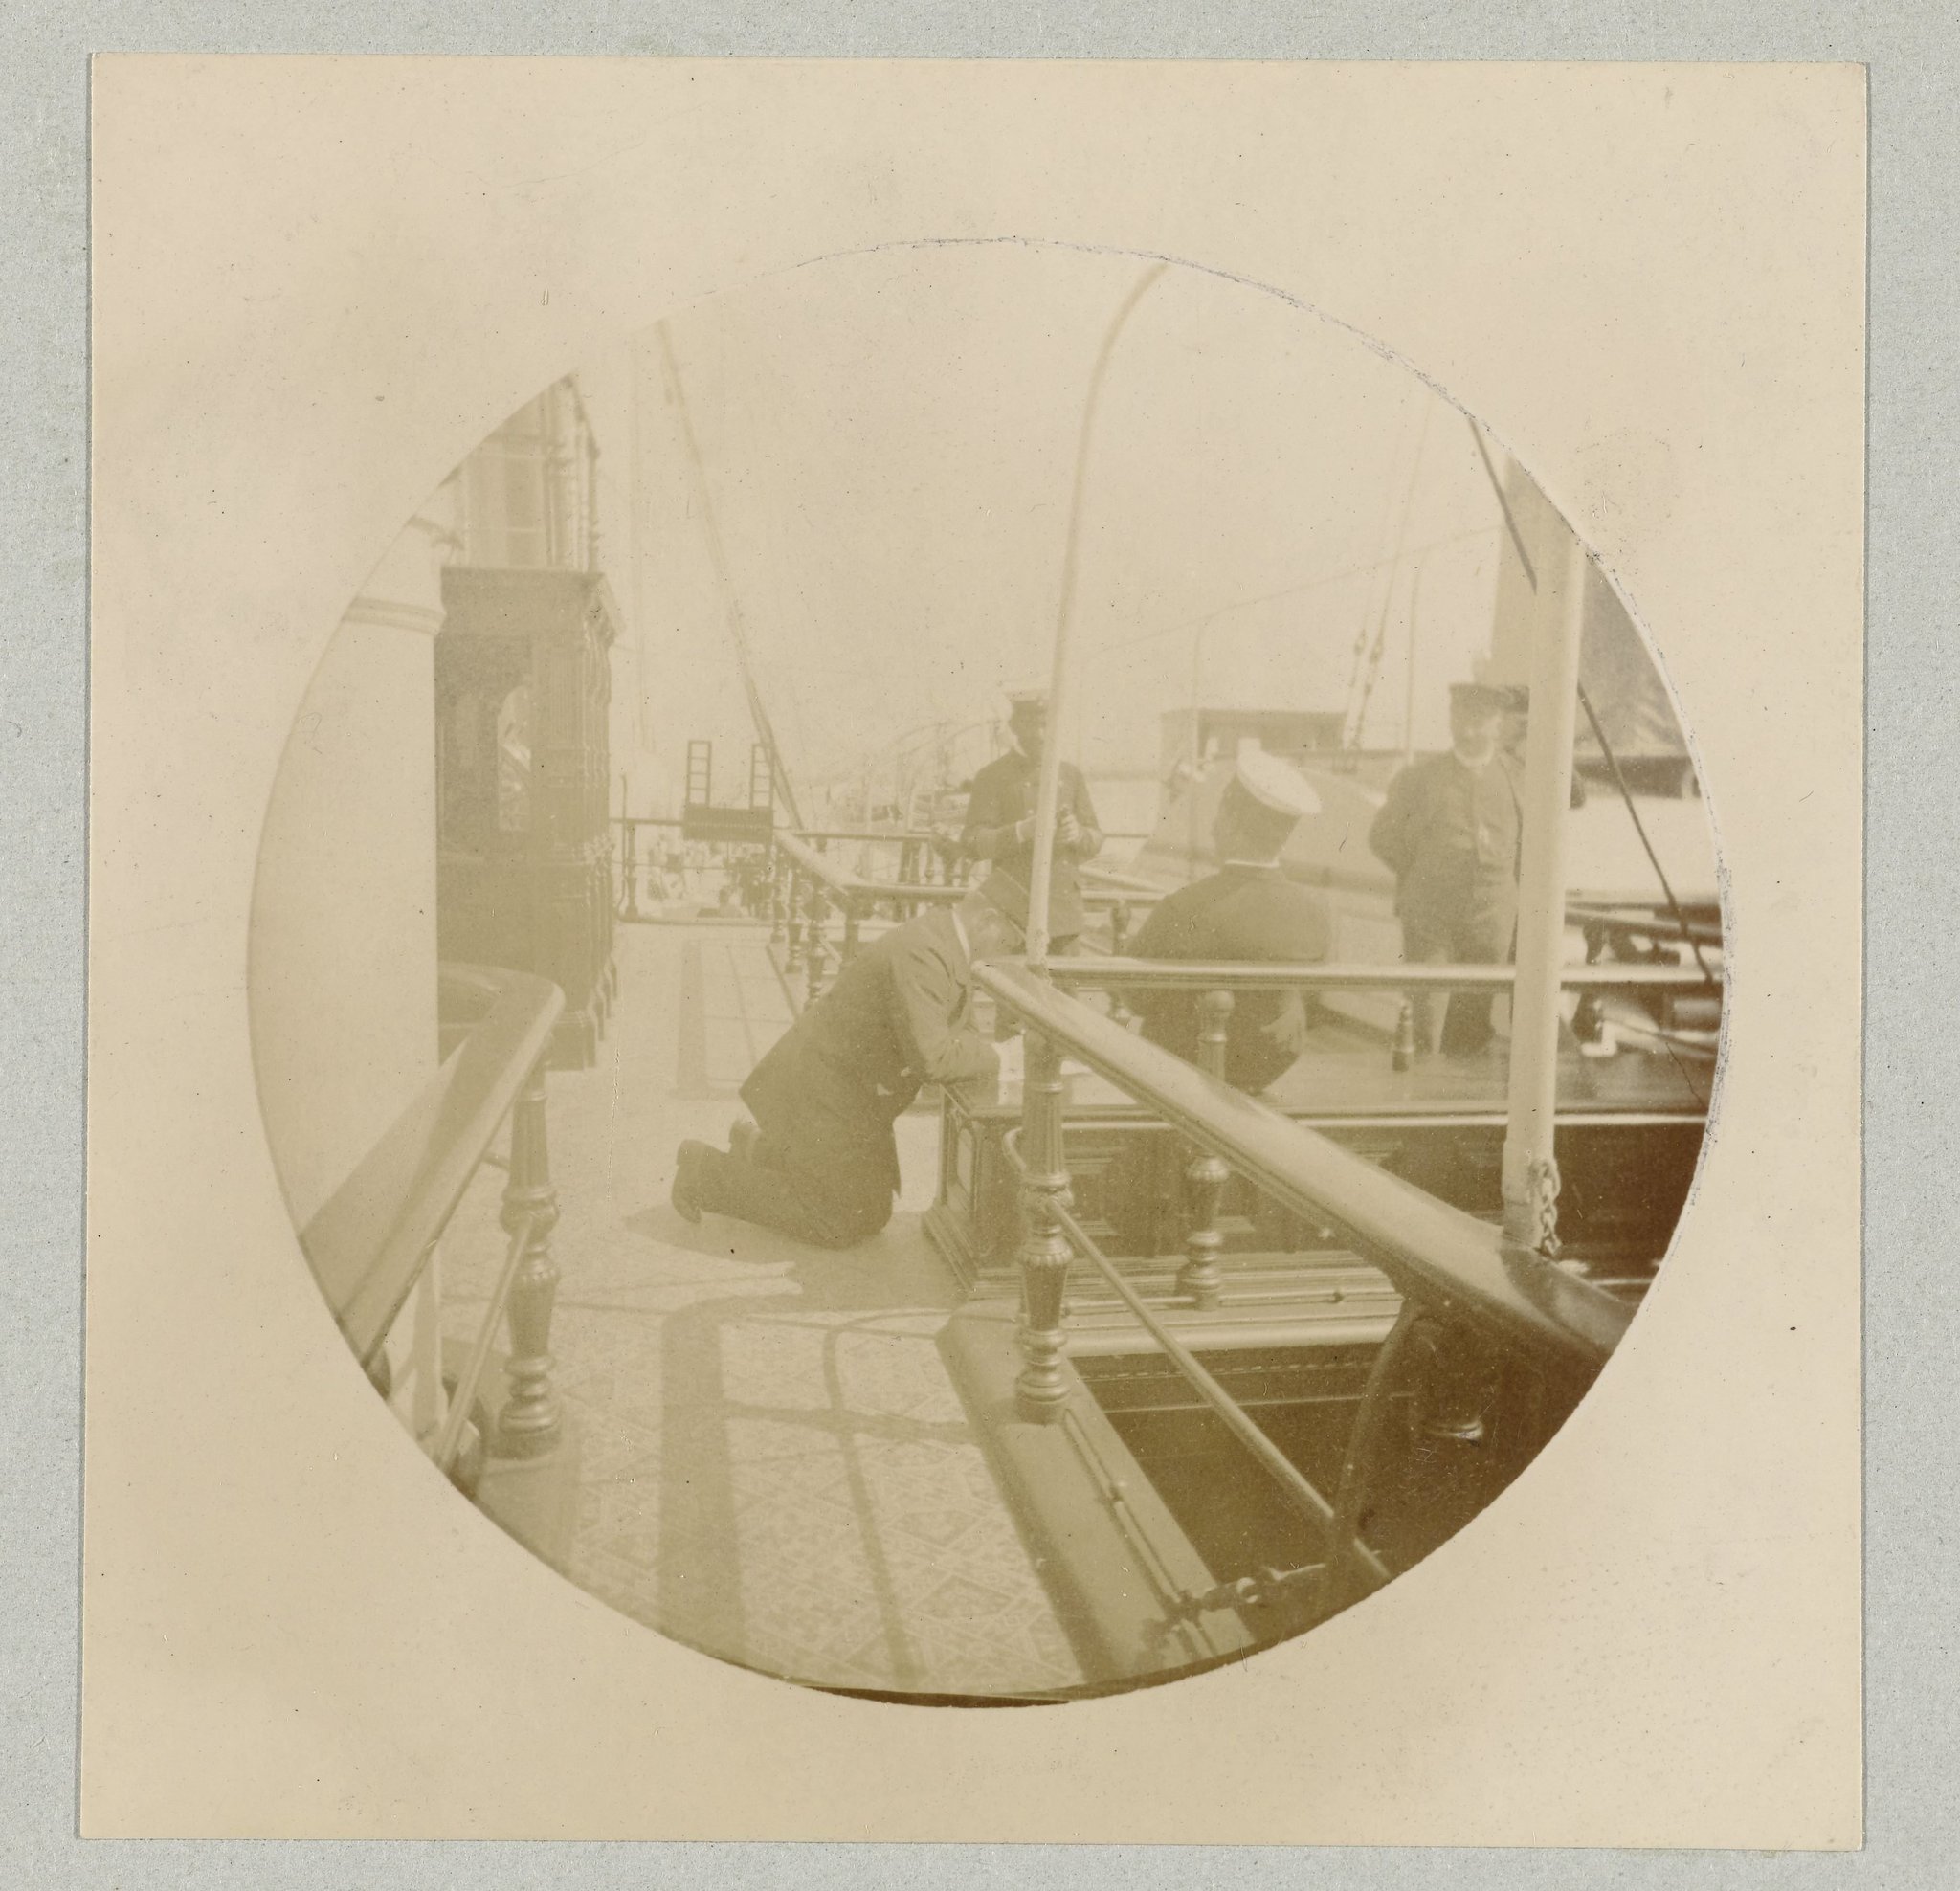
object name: photograph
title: Bemanning aan boord van een schip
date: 1807-1889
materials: cardboard, paper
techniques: gelatin silver print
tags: wilhelm ii (keizer van duitsland), norway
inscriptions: number: ‘21’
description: De afdruk van de foto is rond, het papier vierkant. foto gemaakt met Nr. 1 Kodak Camera